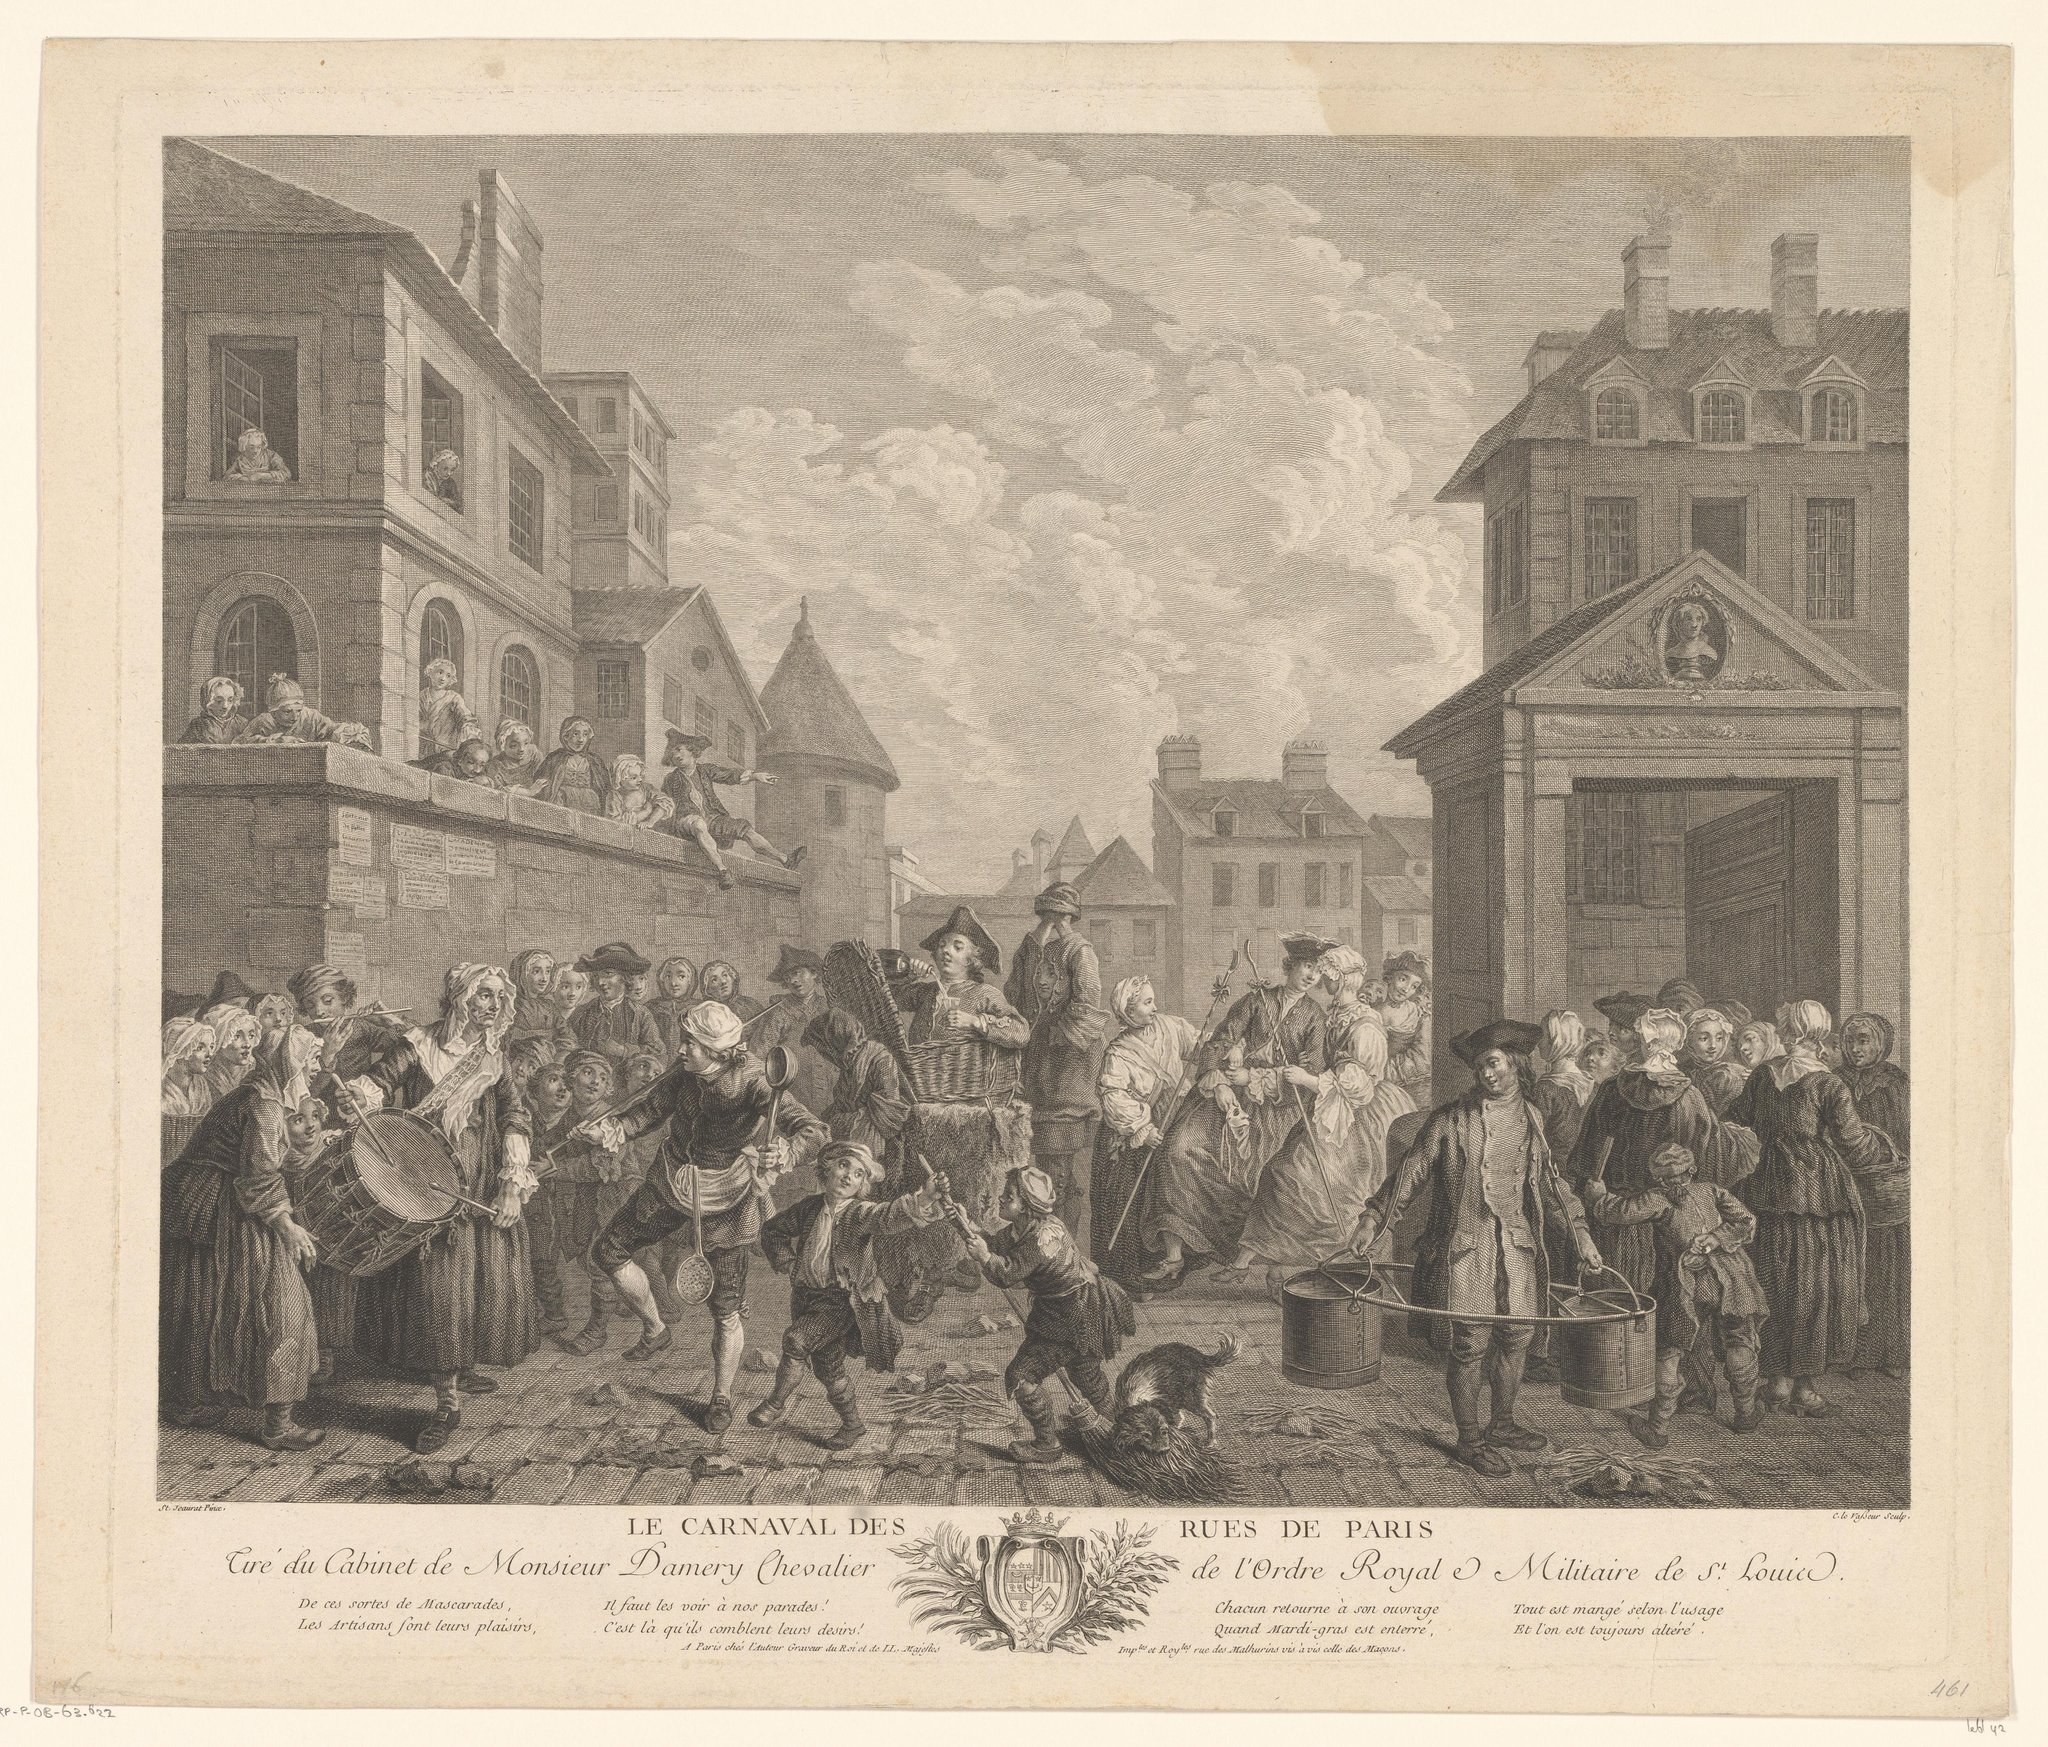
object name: print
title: Le Carnaval des Rues de Paris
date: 1744-1816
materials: paper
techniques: engraving, etching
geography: paris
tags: public festivities, carnival, shrovetide (non-liturgical celebration), armorial bearing, heraldry, paris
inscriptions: collector's mark: Lugt 2228